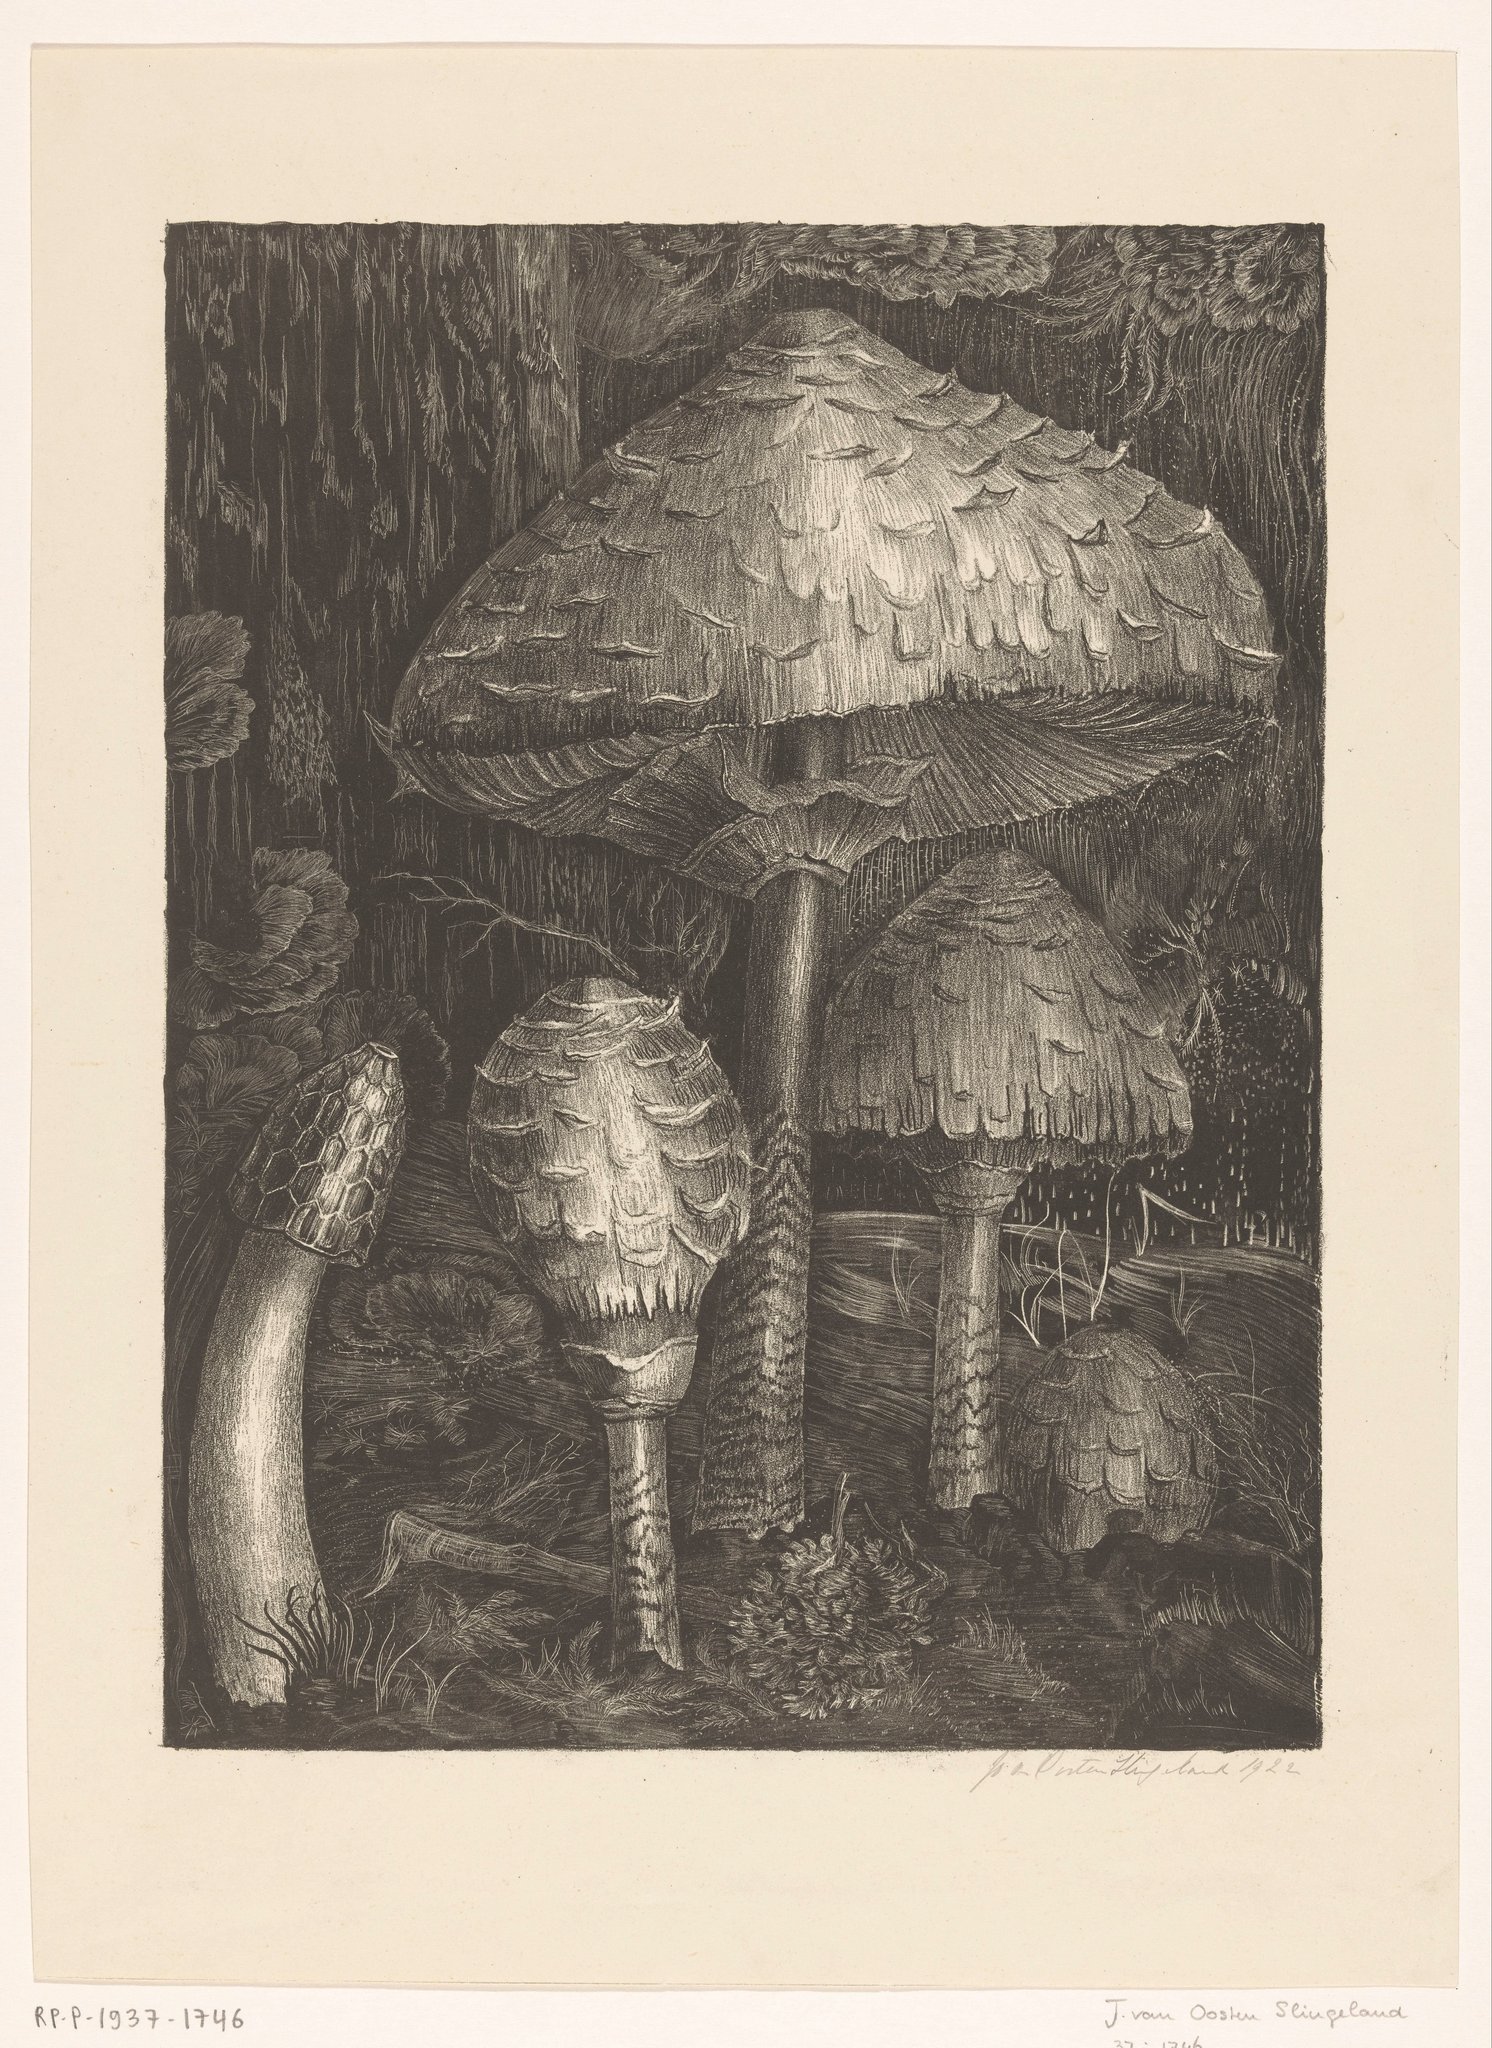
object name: print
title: Paddenstoelen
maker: jo van oosten slingeland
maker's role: draughtsman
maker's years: 1877-1945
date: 1922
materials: paper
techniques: lithograph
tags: mushrooms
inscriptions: collector's mark: Lugt 2760, collector's mark: Lugt 2228